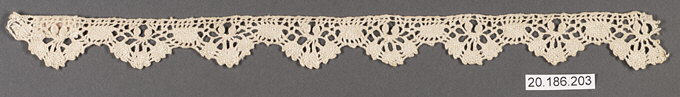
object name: edging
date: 1601-1700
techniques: lace